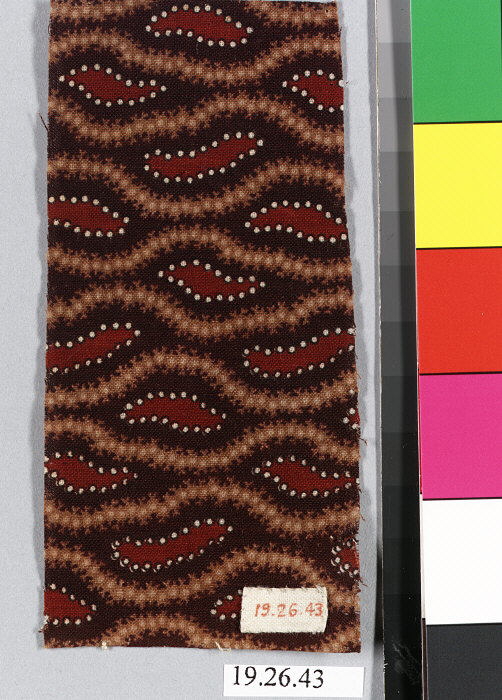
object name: sample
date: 1840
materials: cotton